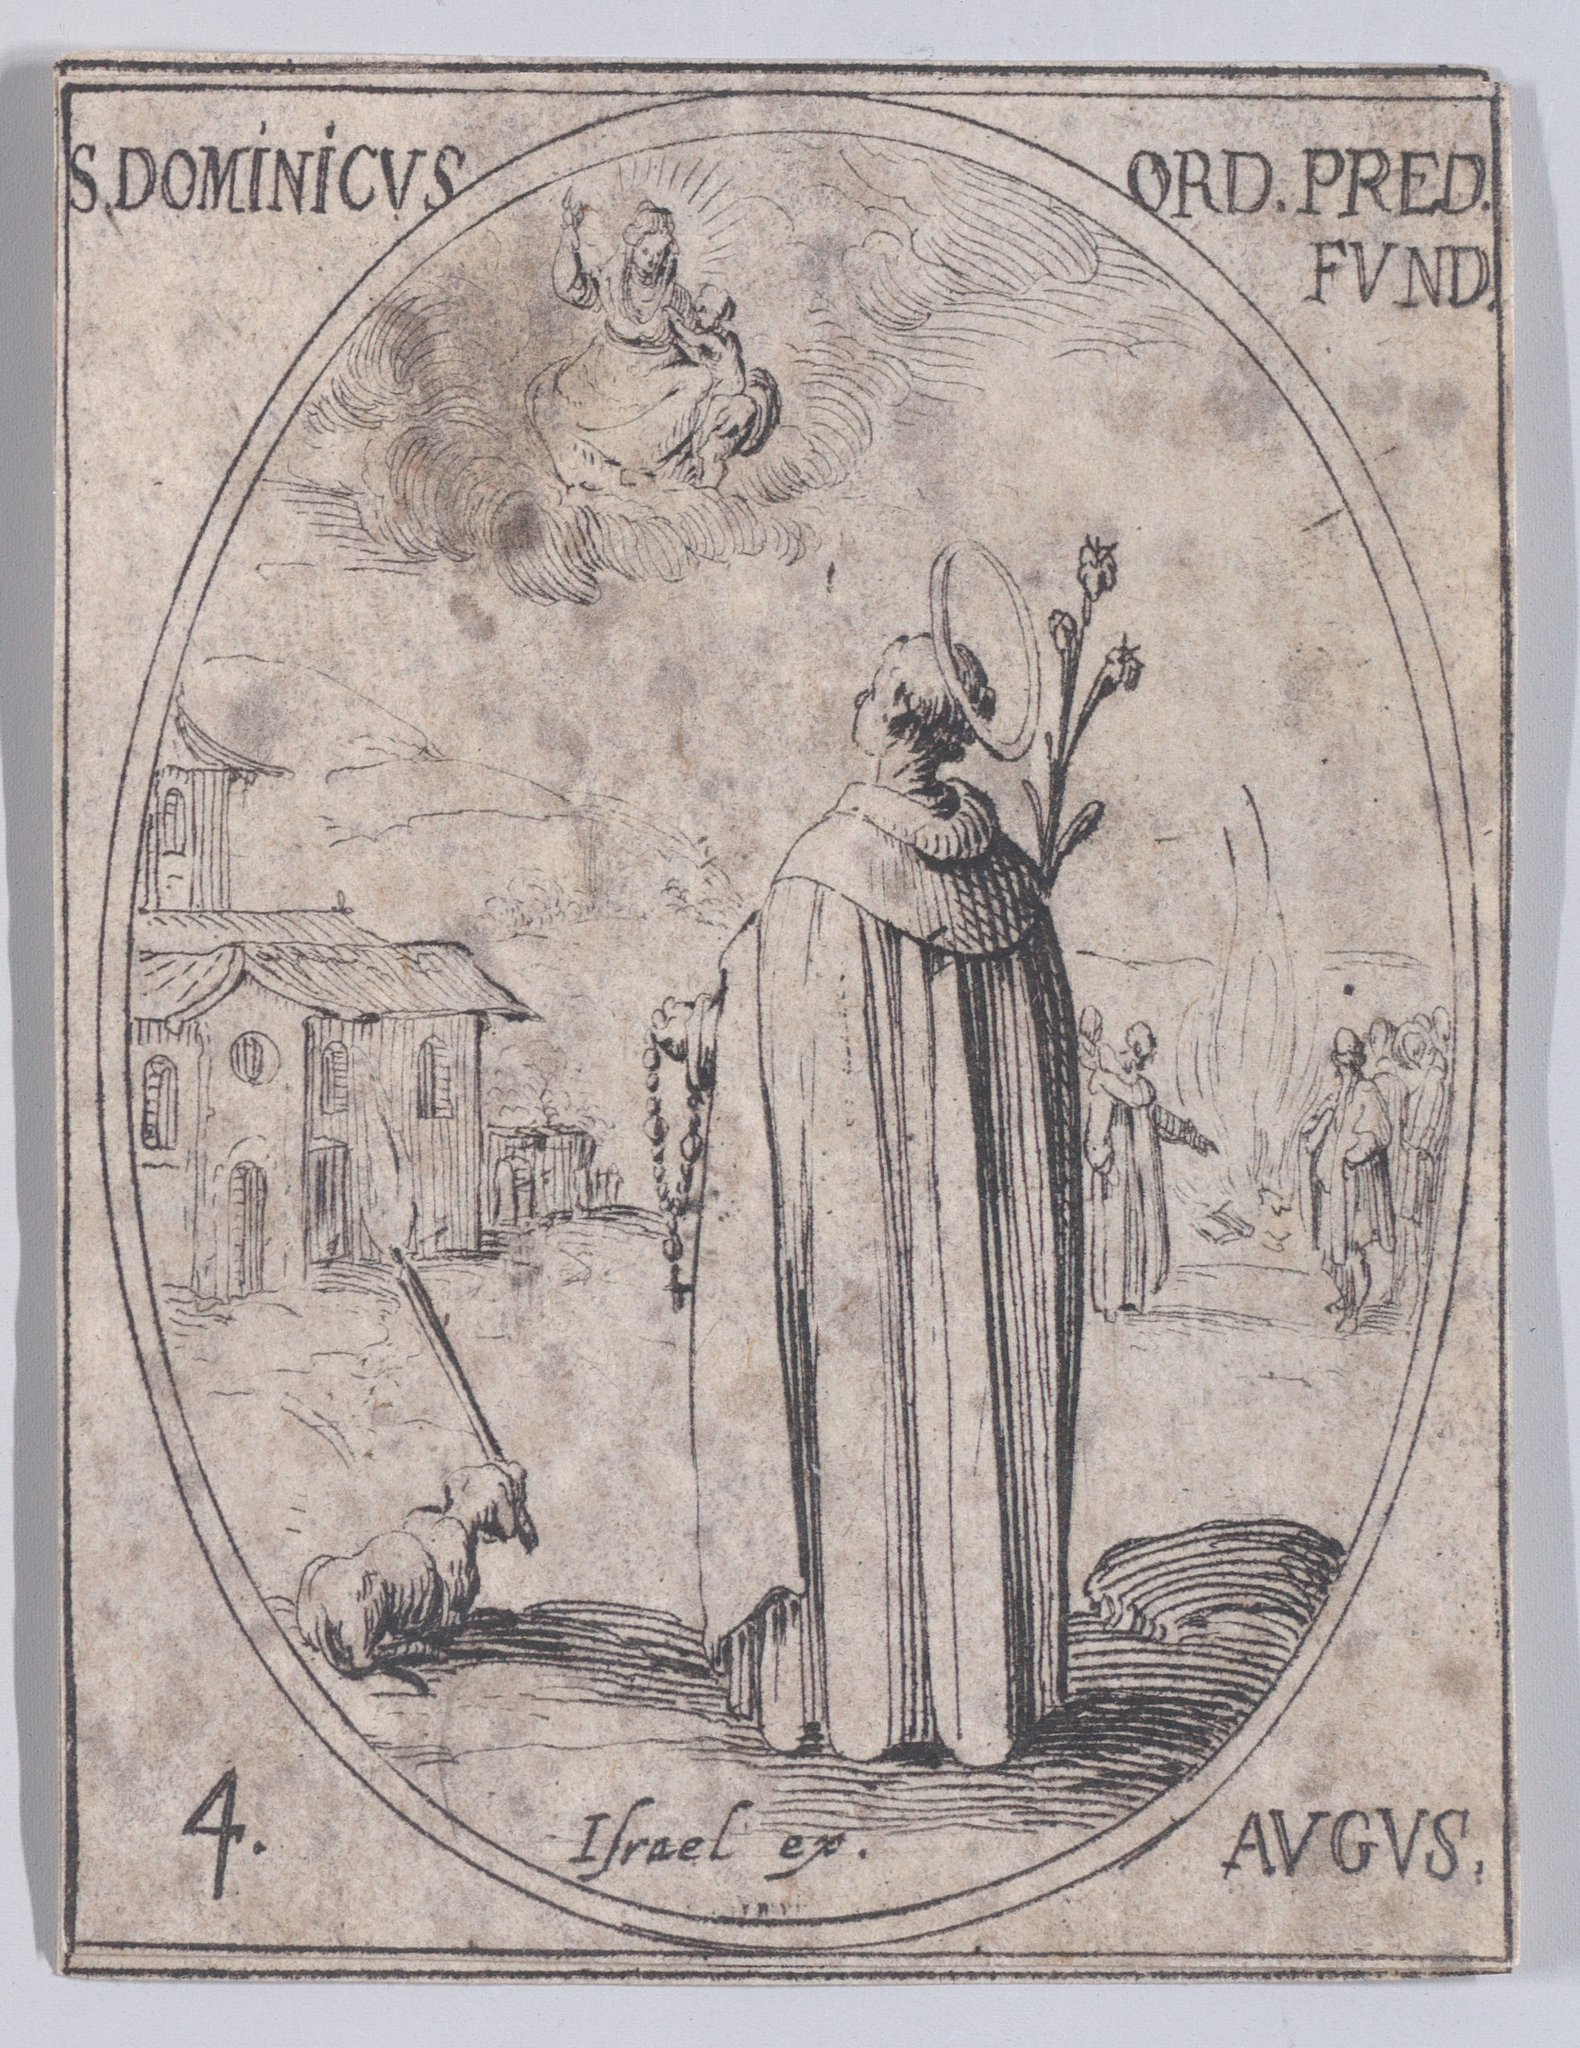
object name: print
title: S. Dominique, fondateur de l'Ordre des Pères Prêcheurs (St. Dominic, Founder of the Order of Preachers), August 4th, from "Les Images De Tous Les Saincts et Saintes de L'Année" (Images of All of the Saints and Religious Events of the Year)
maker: jacques callot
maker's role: artist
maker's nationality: french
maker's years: 1592-1635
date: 1636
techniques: etching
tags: men,dogs,saints